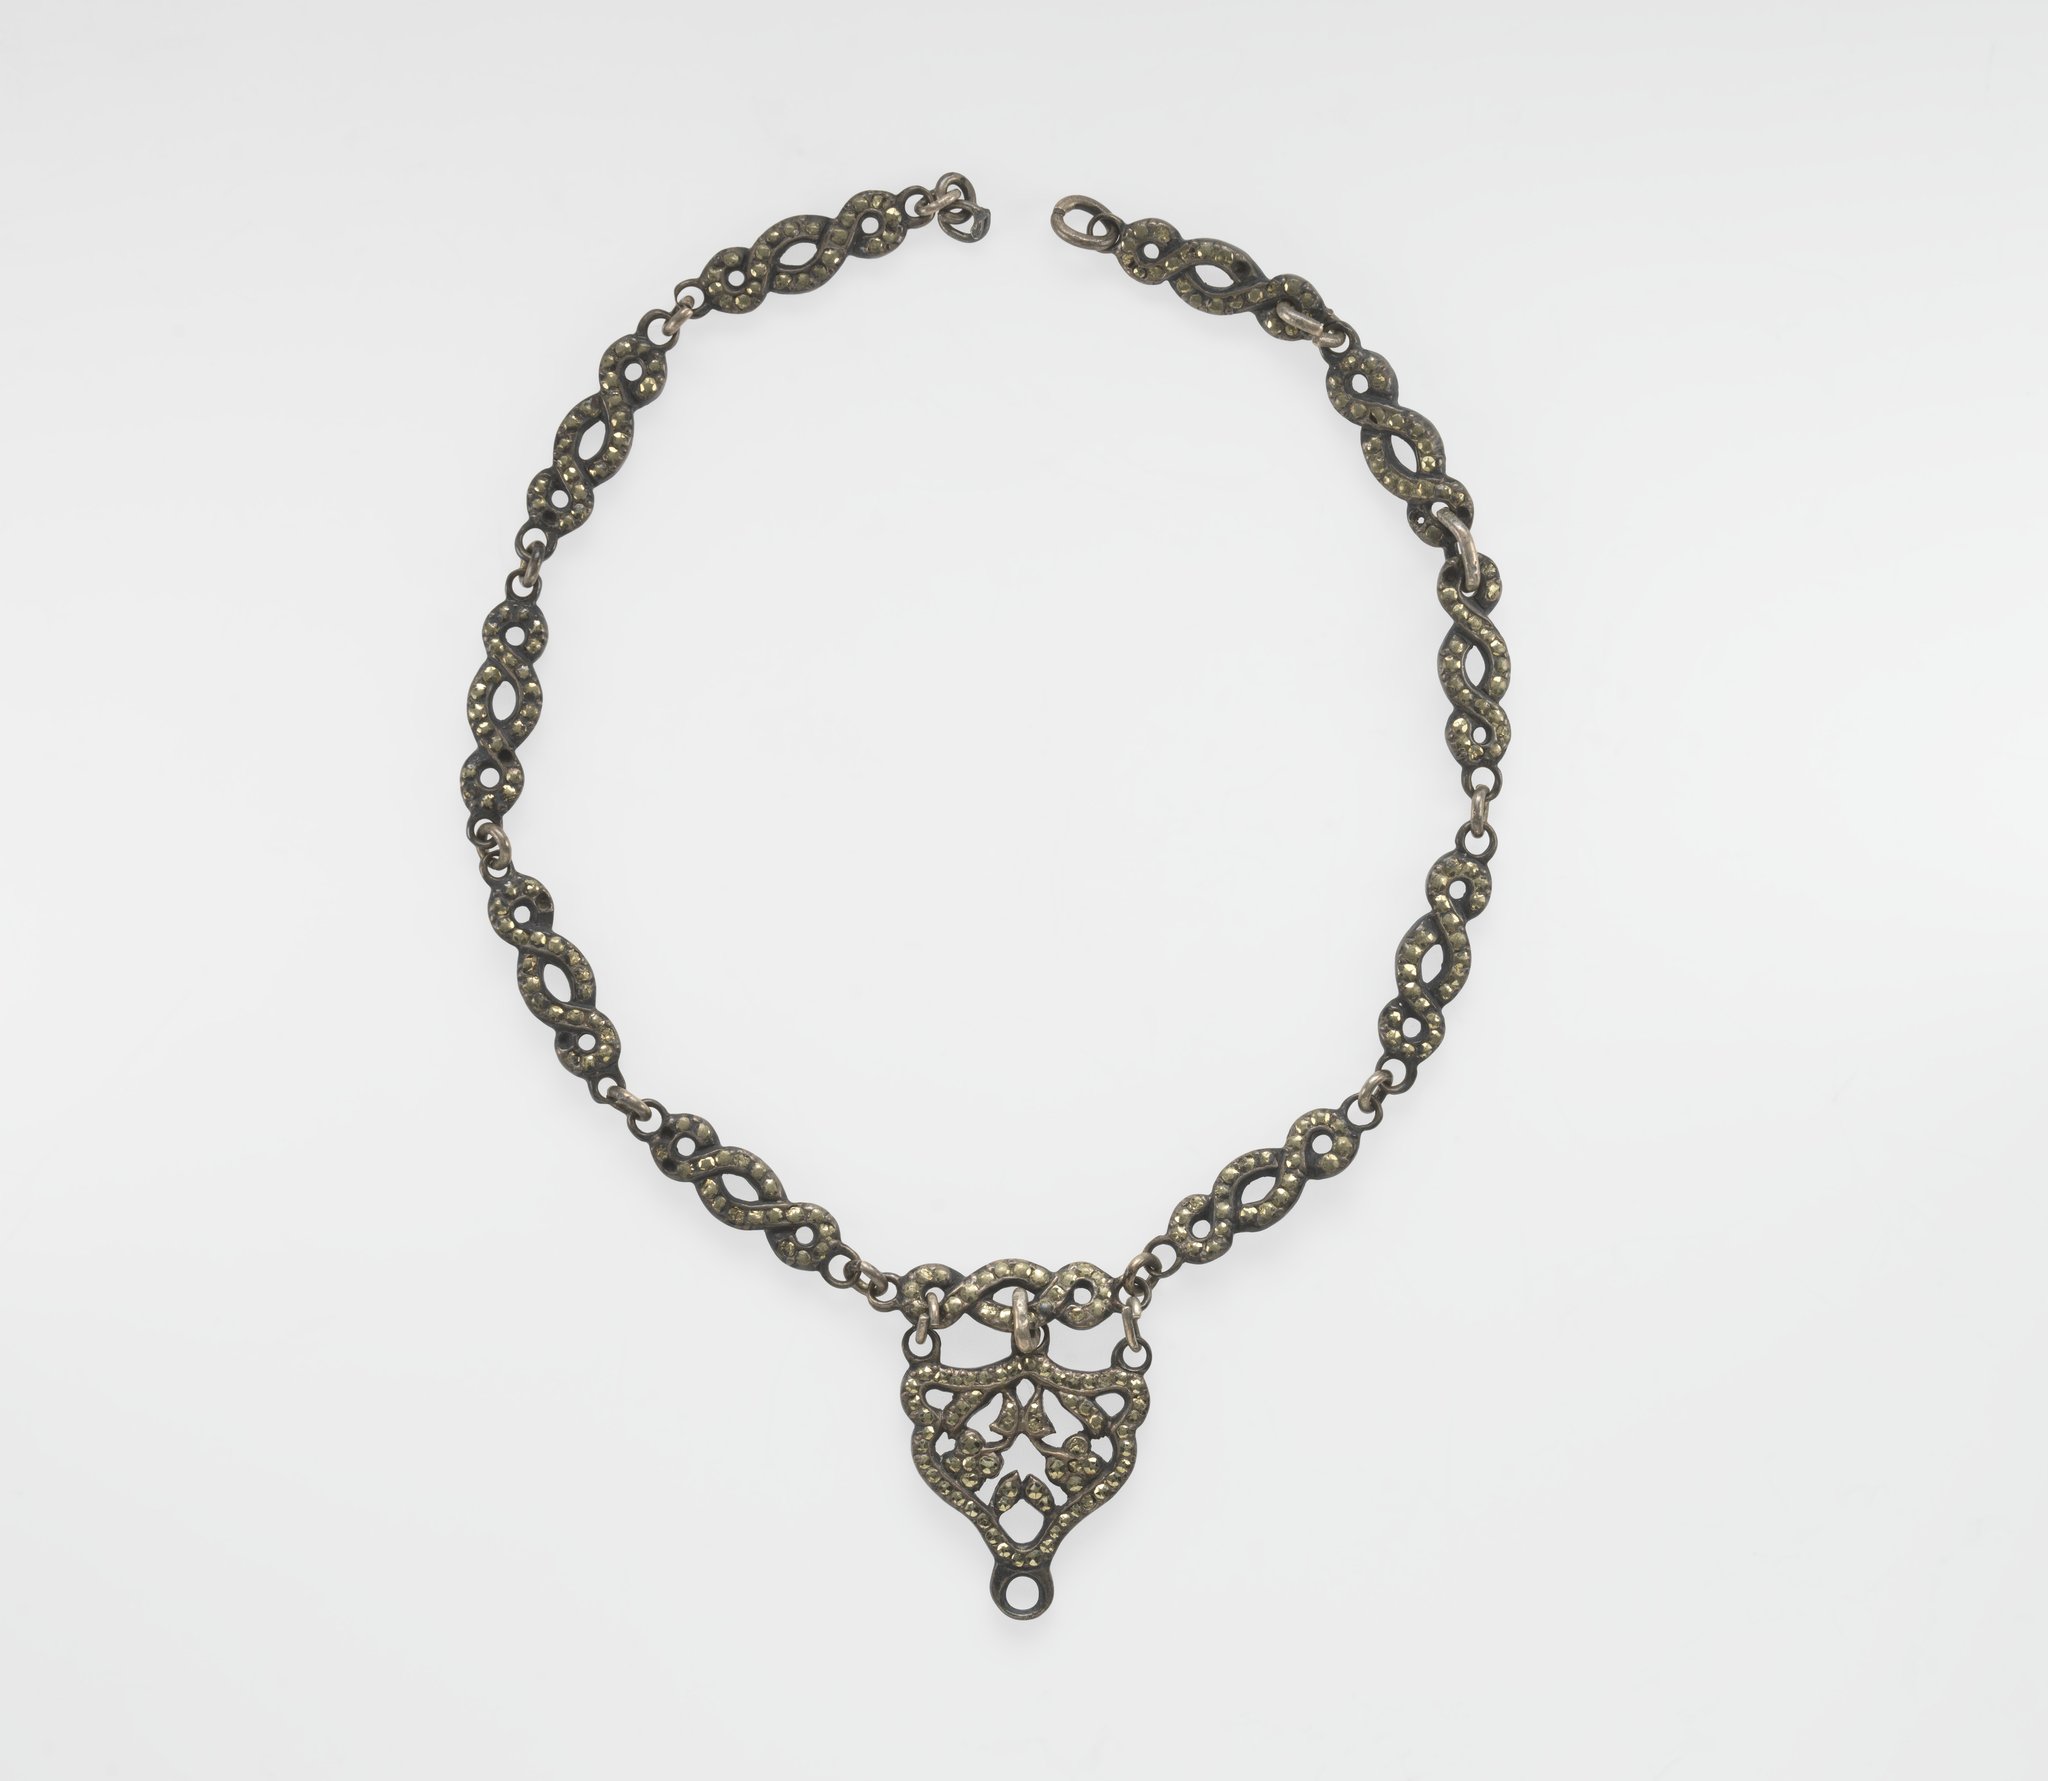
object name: necklace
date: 1801-1900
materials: silver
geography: india